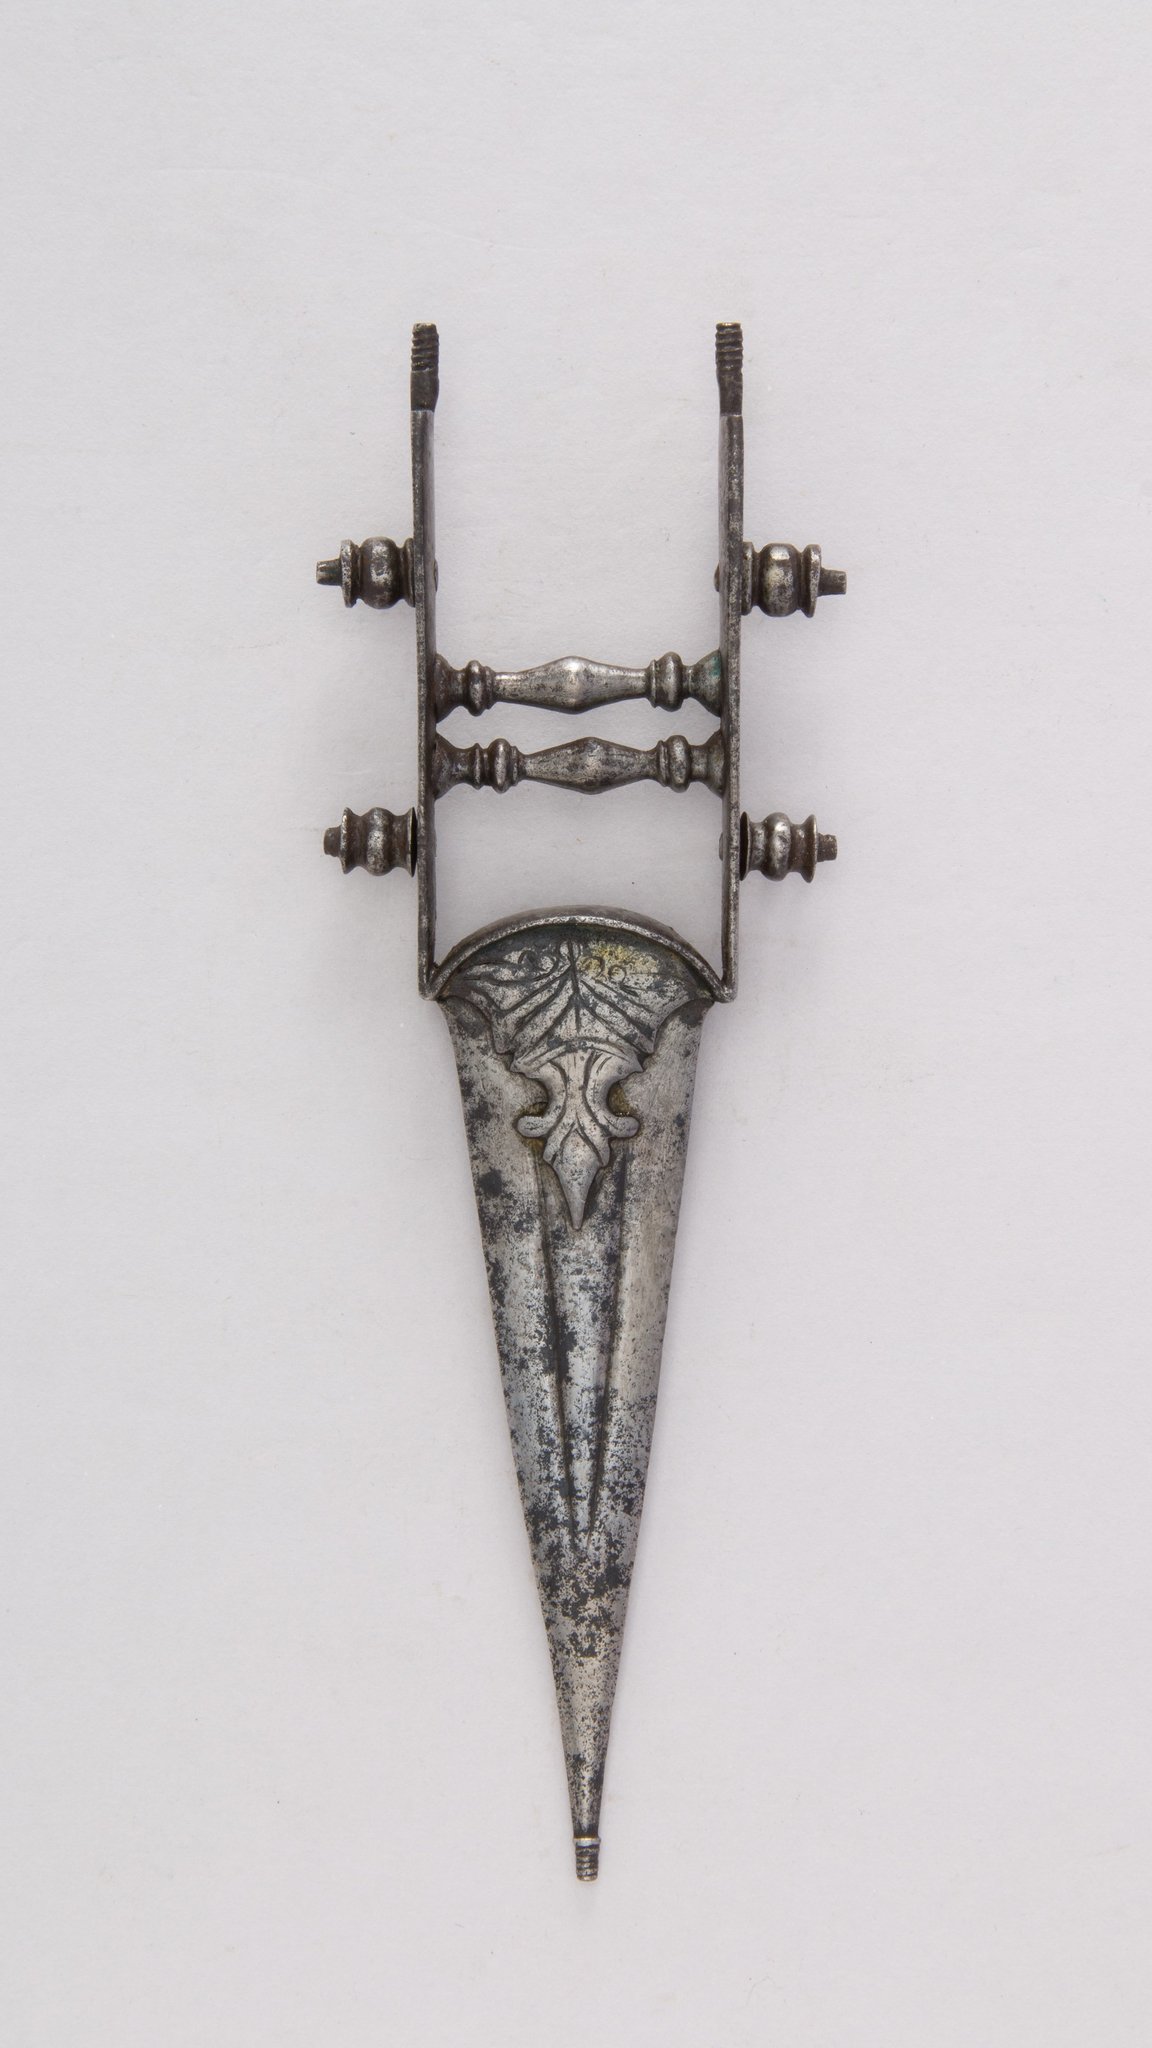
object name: dagger katar model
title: Dagger (Katar) Model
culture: indian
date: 1767-1900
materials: steel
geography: north india